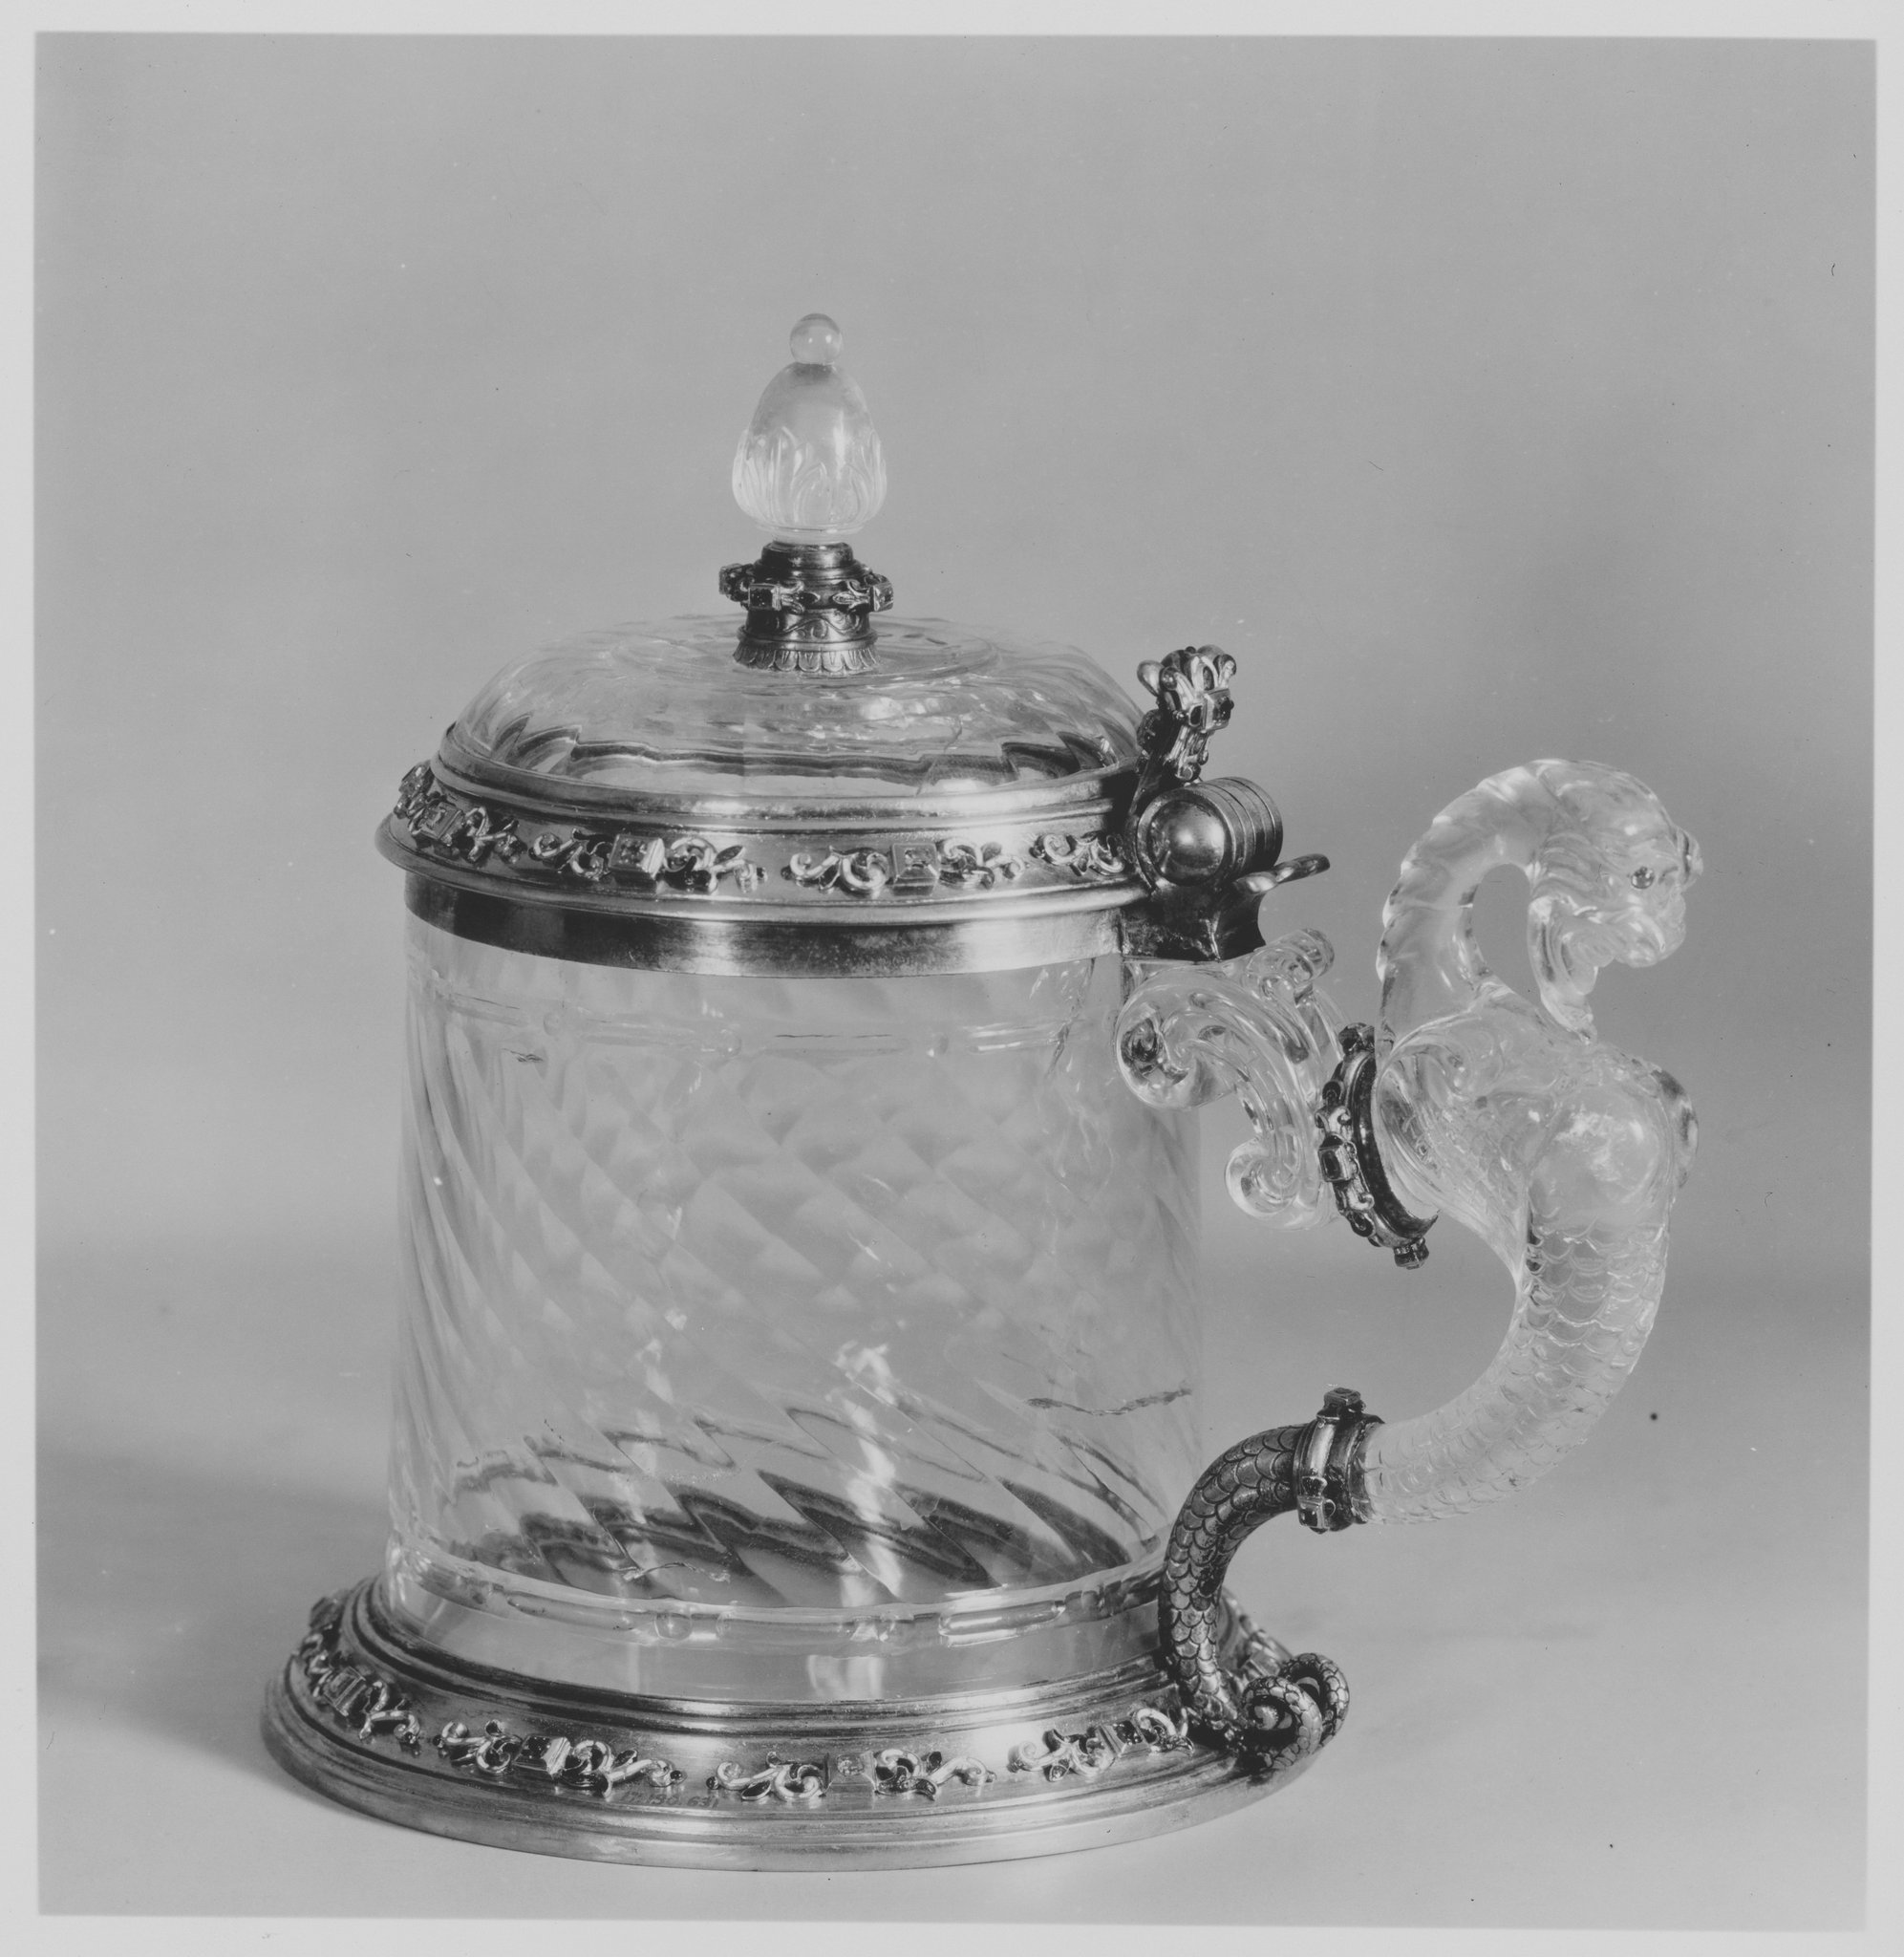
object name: tankard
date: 1801-1900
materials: enamel, gold, quartz, silver gilt